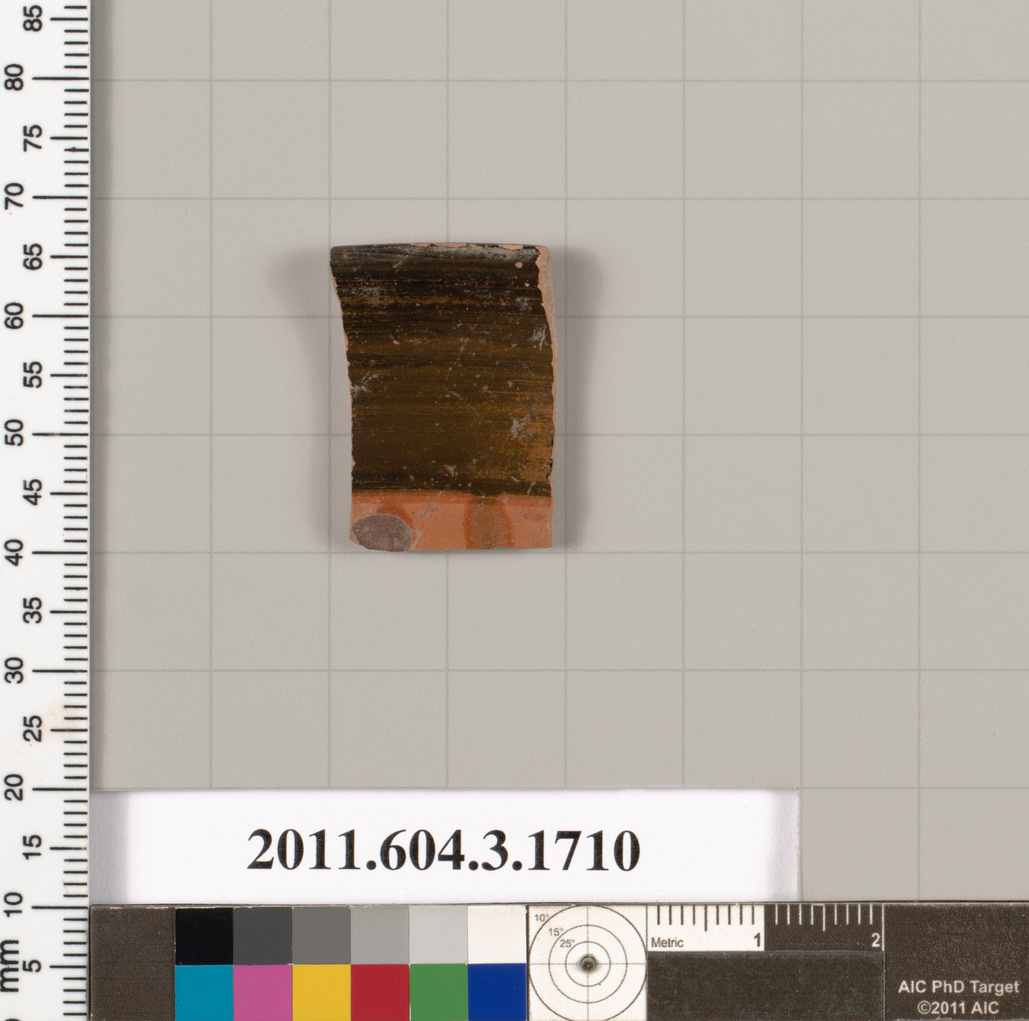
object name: kylix fragment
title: Terracotta rim fragment of a kylix: Band cup (drinking cup)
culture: greek, attic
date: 550-526 BCE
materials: terracotta